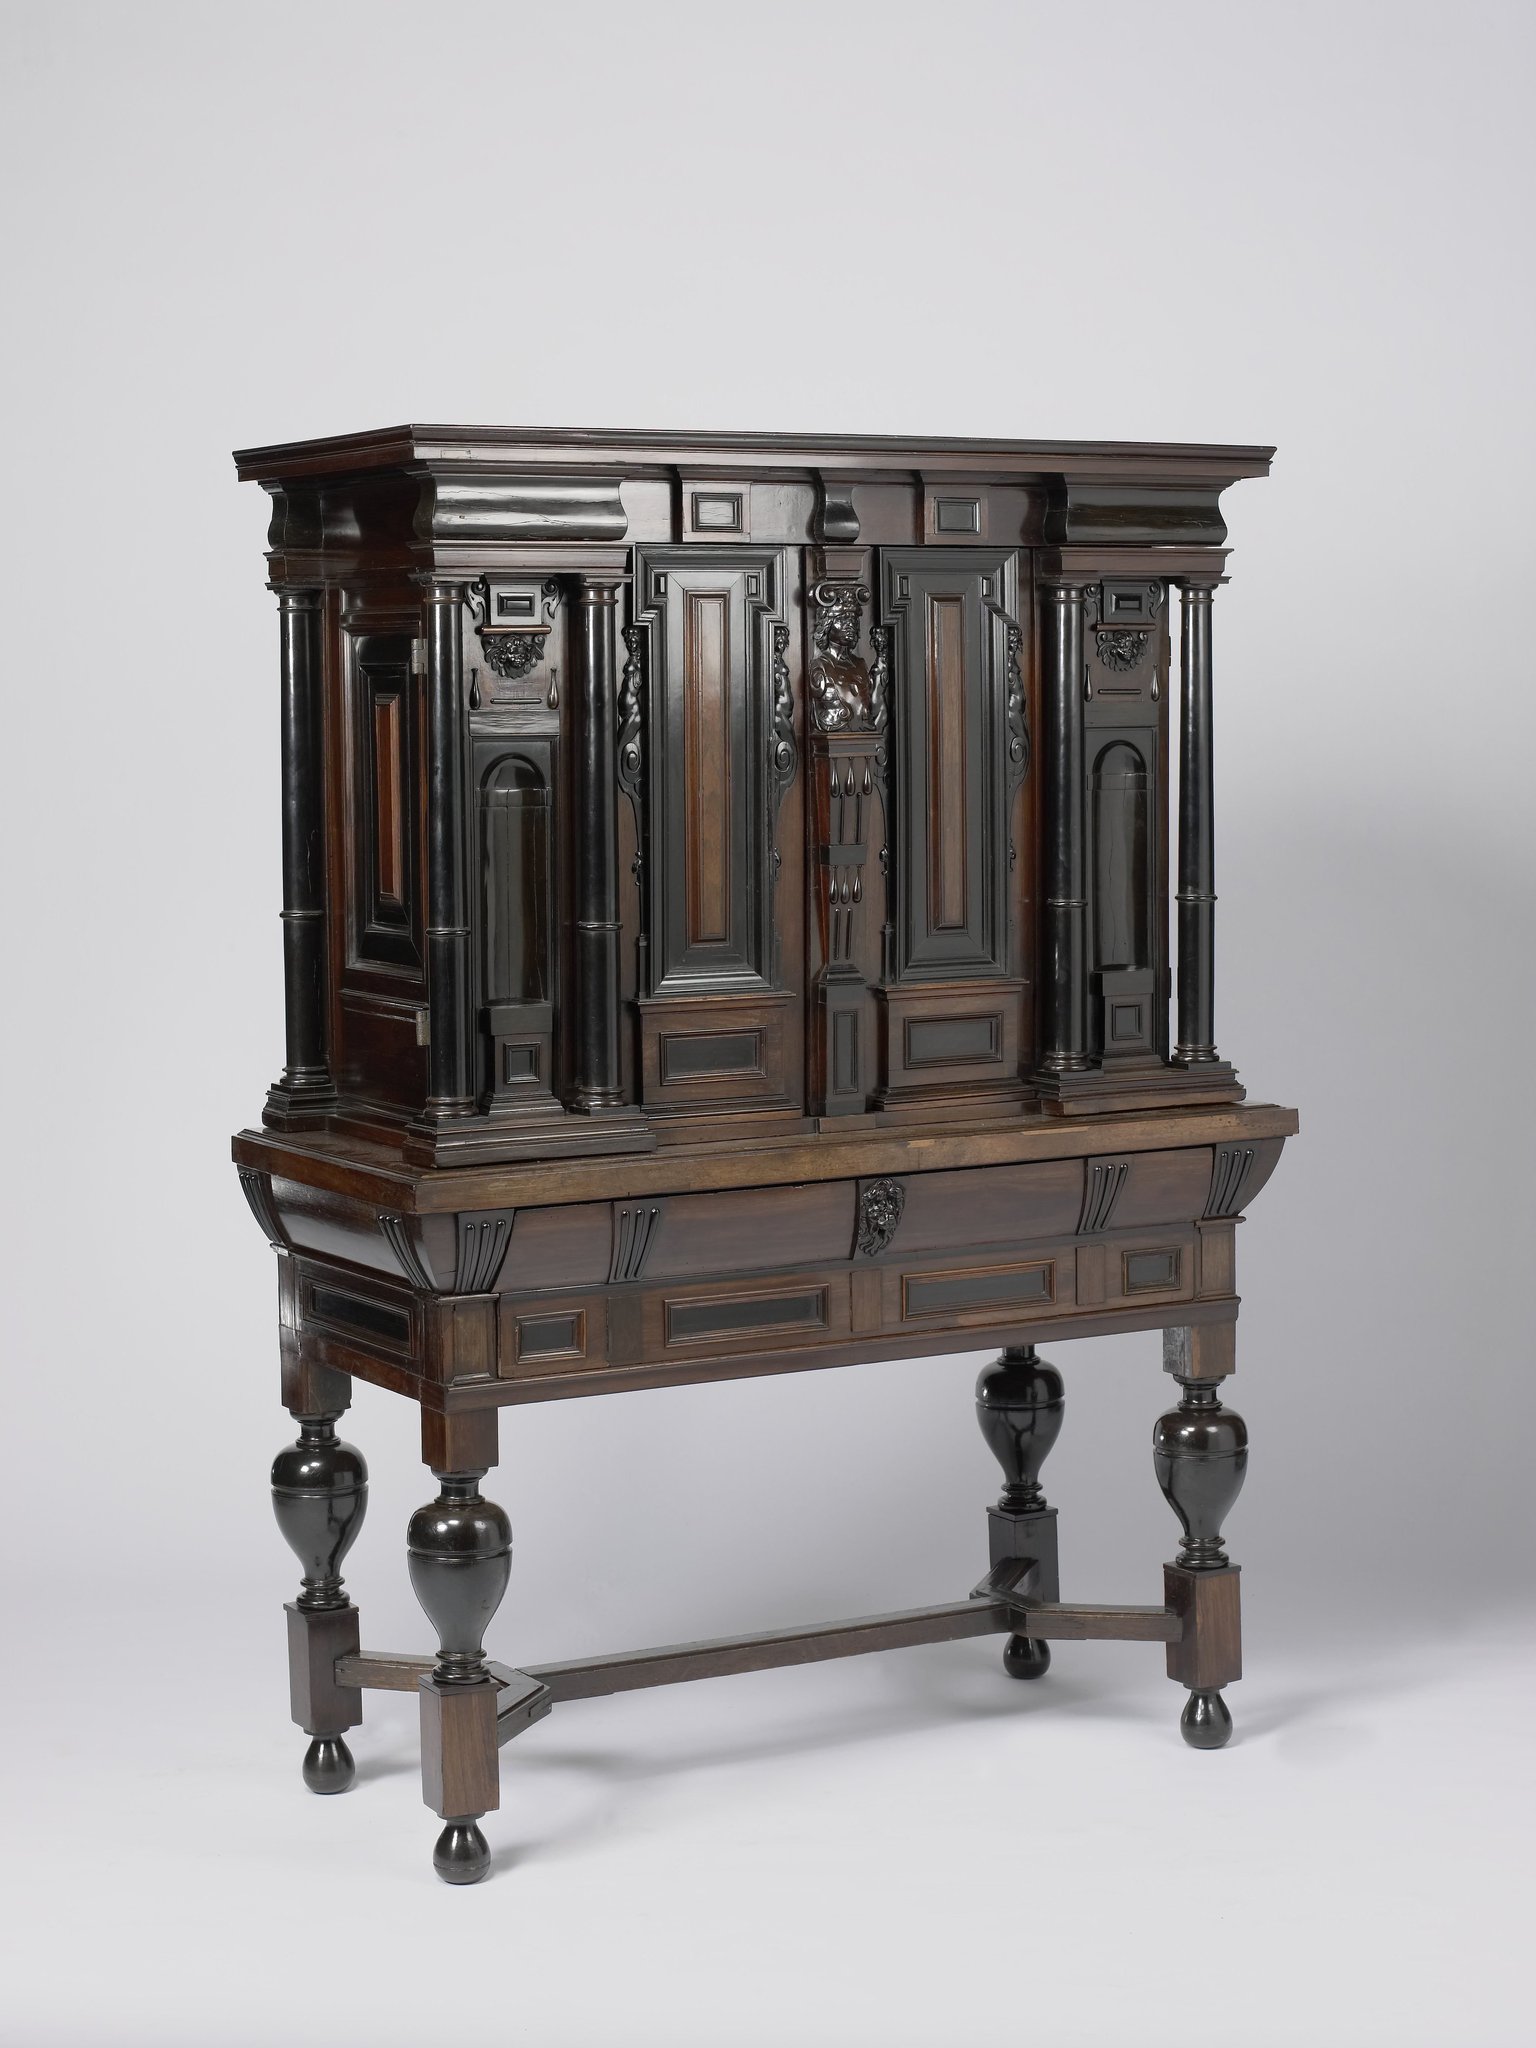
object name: furniture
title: Tafelkast belijmd met palissander- en ebbenhout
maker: herman doomer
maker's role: woodworker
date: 1635-1650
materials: wood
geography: amsterdam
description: Cabinet. Oak, veneered with rosewood and ebony. Amsterdam, c. 1635 - 1650, attributed to Herman Doomer.